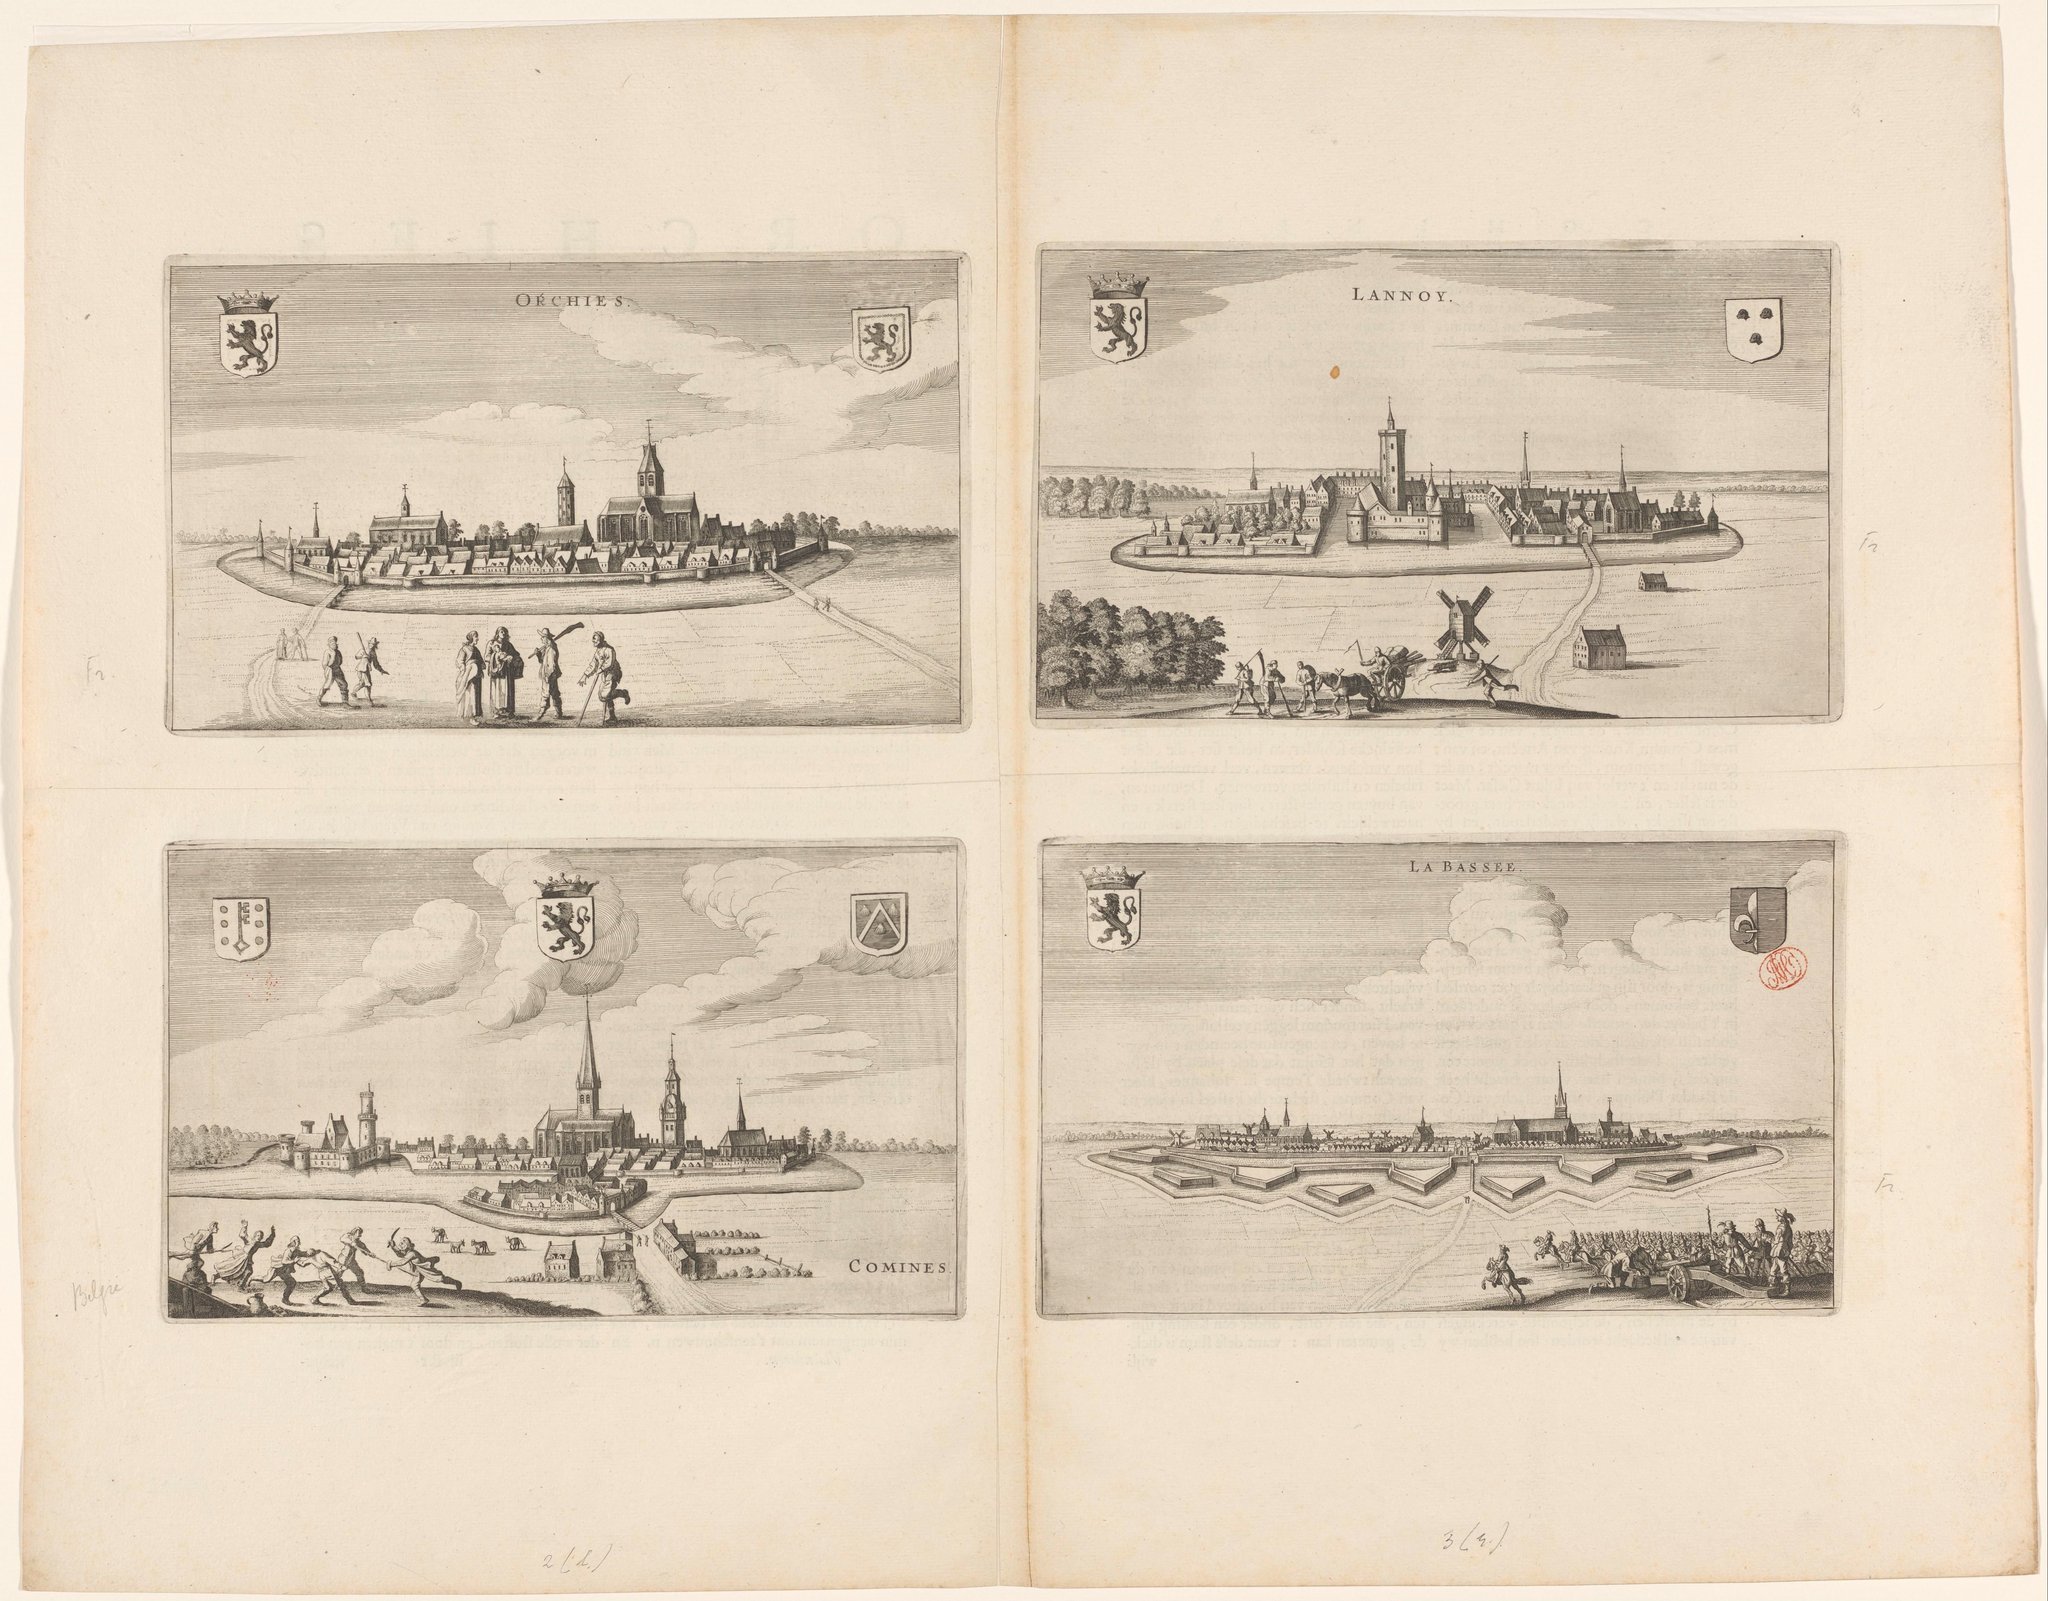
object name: print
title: Orchies / Lannoy / La Bassee / Comines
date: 1652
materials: paper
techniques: engraving, etching, letterpress printing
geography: amsterdam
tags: coat of arms (as symbol of the state, etc.) (+ city; municipal), attack ~ siege, fortified city, coat of arms (as symbol of the state, etc.) (+ province; provincial), fighting, prospect of city, town panorama, silhouette of city, armorial bearing, heraldry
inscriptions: collector's mark: Lugt 195, collector's mark: Lugt 2228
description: Linksboven een gezicht op Orchies, met enkele figuren op de voorgrond. Linksboven het wapen van Vlaanderen en rechtsboven het wapen van Orchies. Rechtsboven een gezicht op Lannoy, met figuren, een koets en een molen op de voorgrond. Linksboven het wapen van Vlaanderen en rechtsboven het wapen van Lannoy. Rechtsonder een gezicht op La Bassée, met op de voorgrond een leger dat de stad bestormt. Linksboven het wapen van Vlaanderen en rechtsboven het wapen van La Bassée. Linksonder een gezicht op Comines, met op de voorgrond een schermutseling tussen enkele figuren. Linksboven het wapen van Comines, boven, in het midden, het wapen van Vlaanderen en rechtsboven het wapen van Phillipe de Commynes. Met Nederlandse tekst op verso.